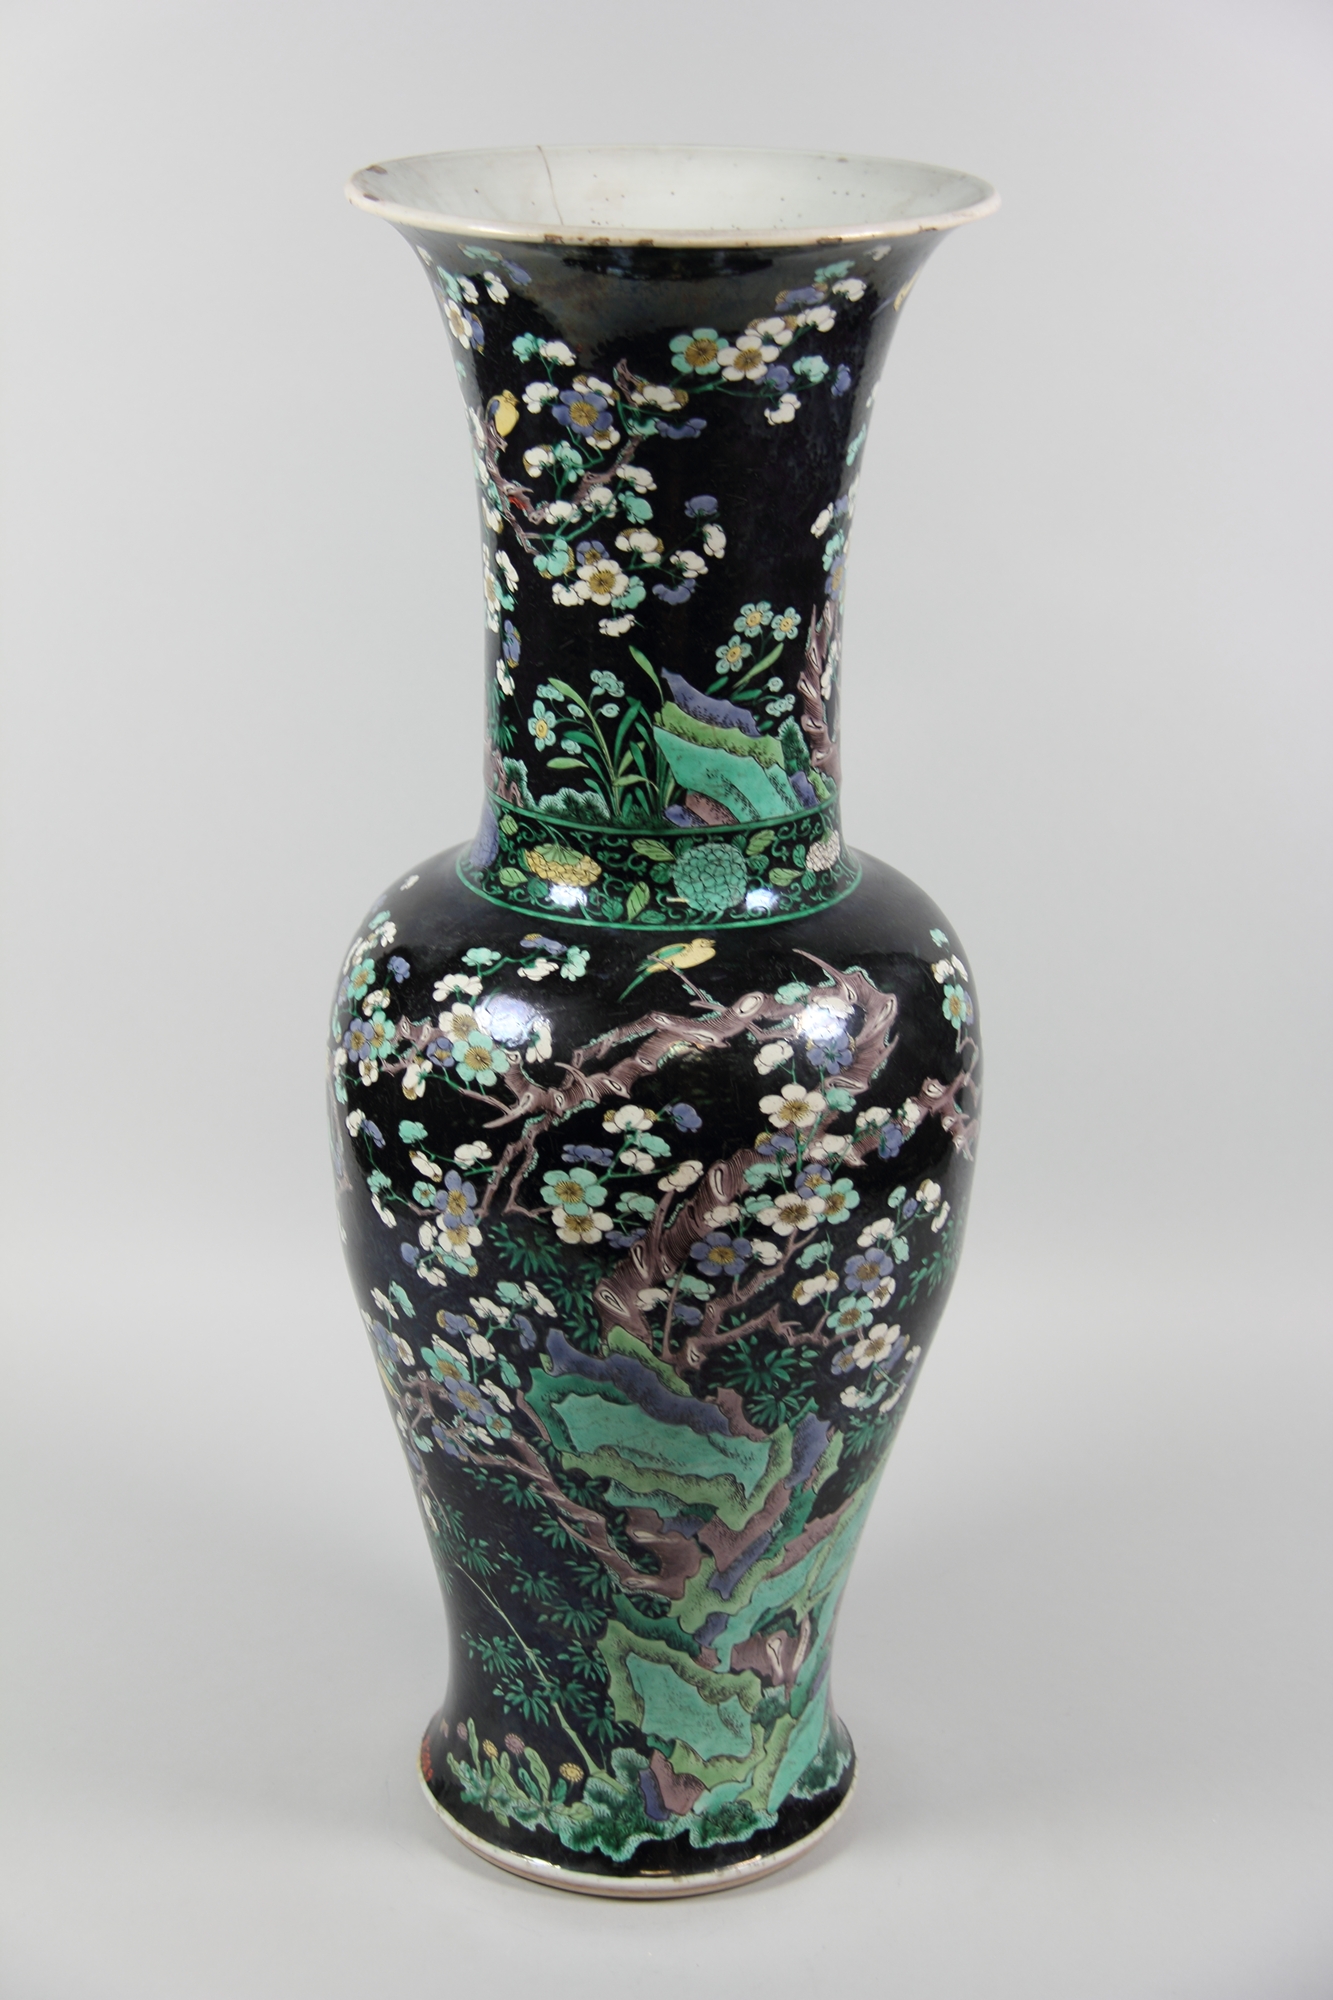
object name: vase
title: Vase with birds and flowers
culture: chinese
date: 1801-1900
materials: enamel, porcelain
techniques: painting, polychrome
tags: flowers